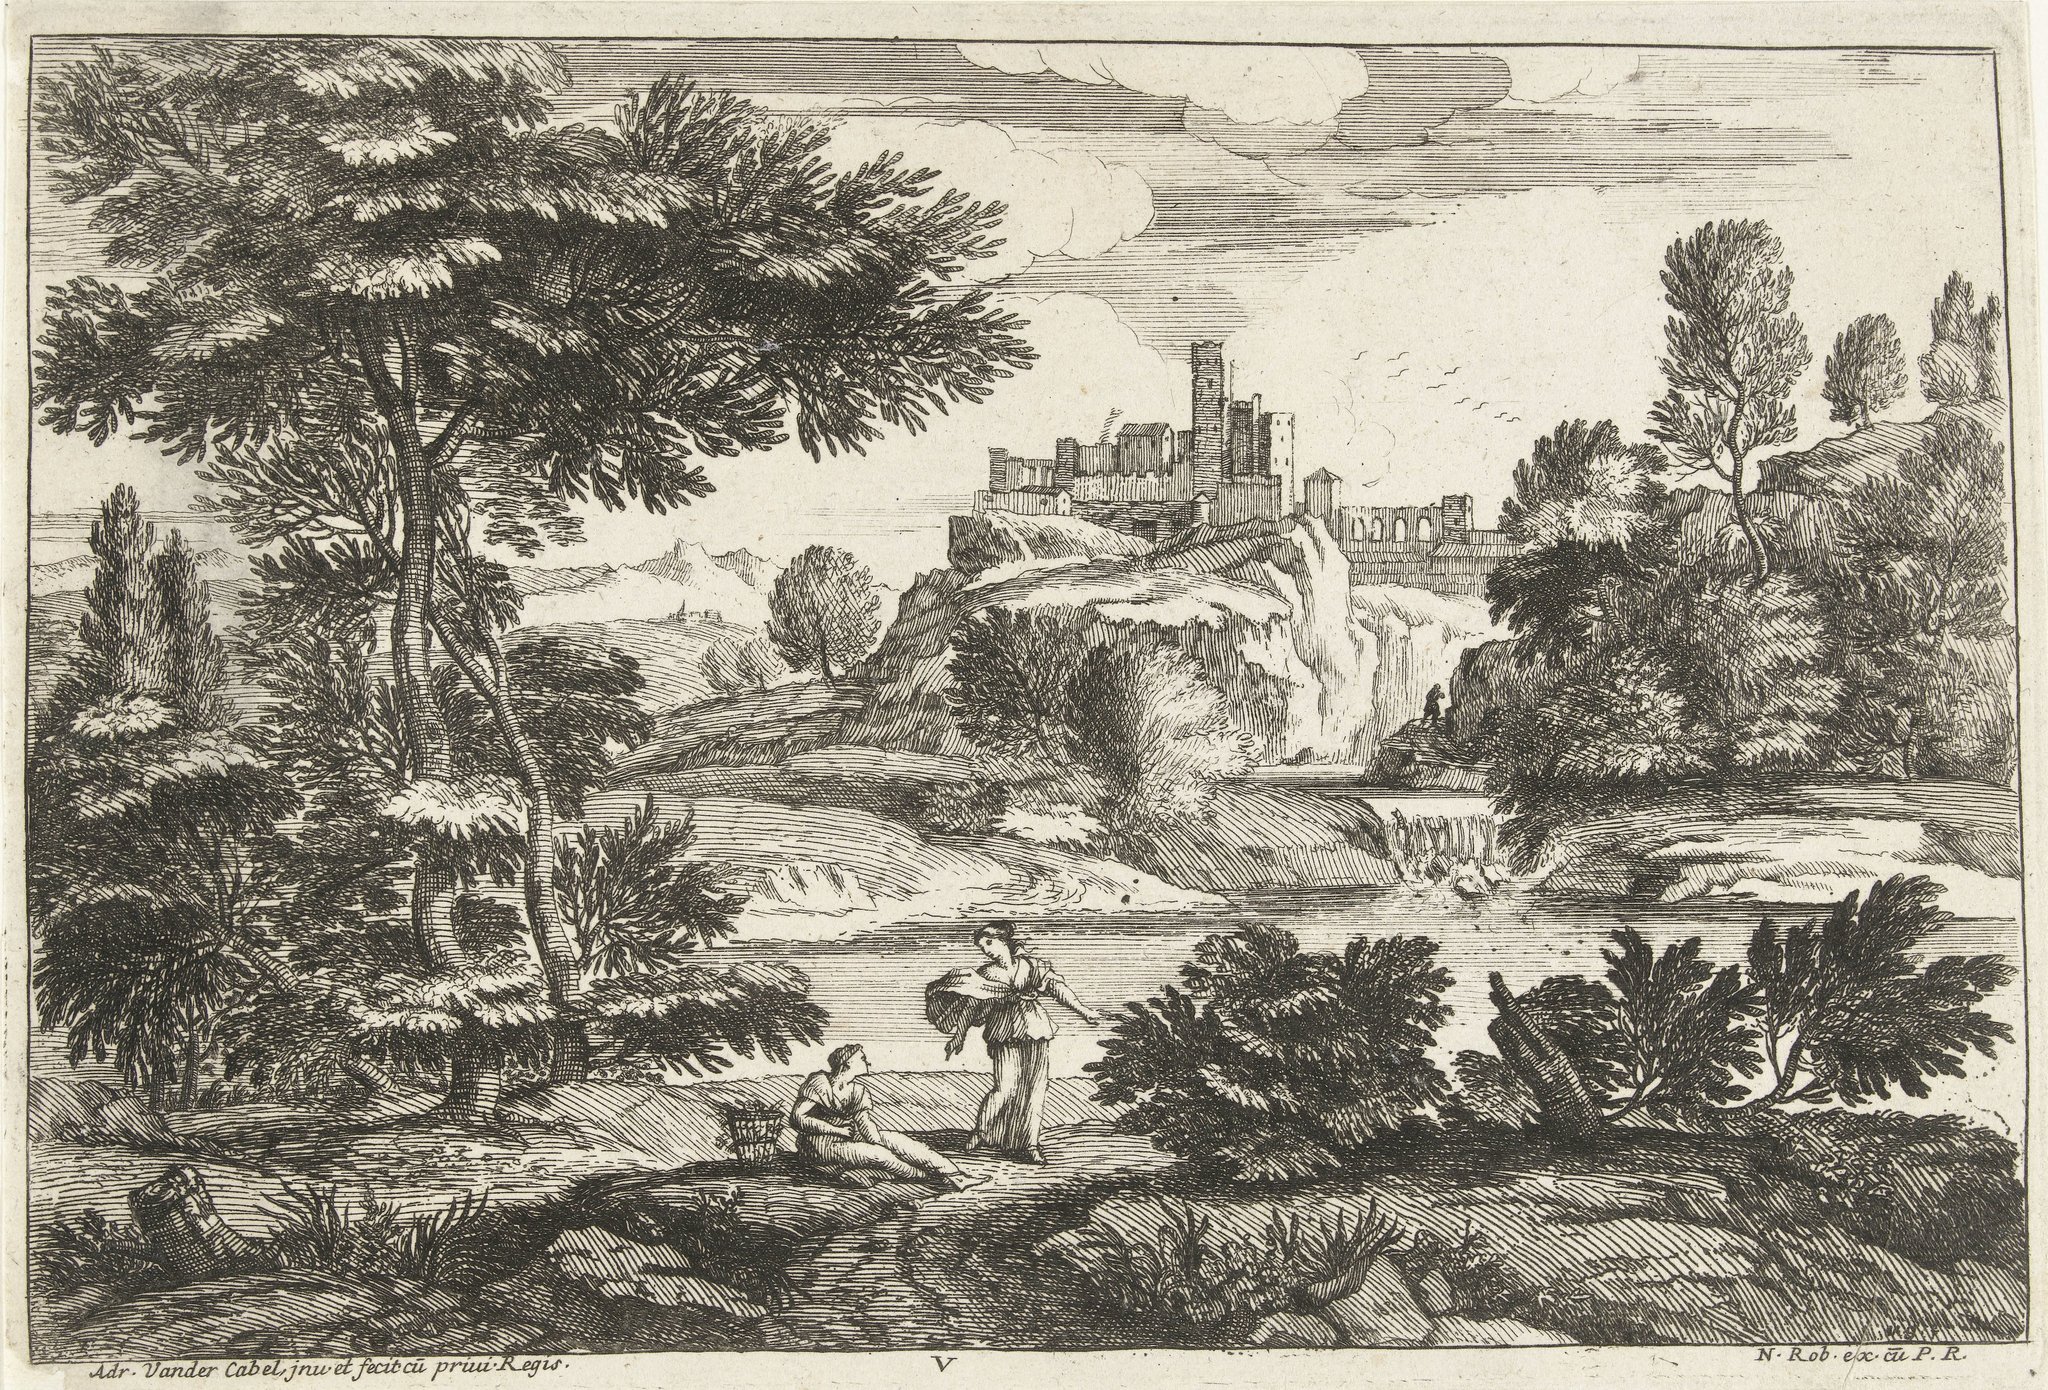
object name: print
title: Landschap met twee vrouwen bij de waterkant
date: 1648-1705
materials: paper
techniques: etching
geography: france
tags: landscapes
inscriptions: collector's mark: Lugt 2228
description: Landschap met staande vrouw kijkend naar zittende vrouw bij mand. Op de achtergrond een rivier en een bergdorp.